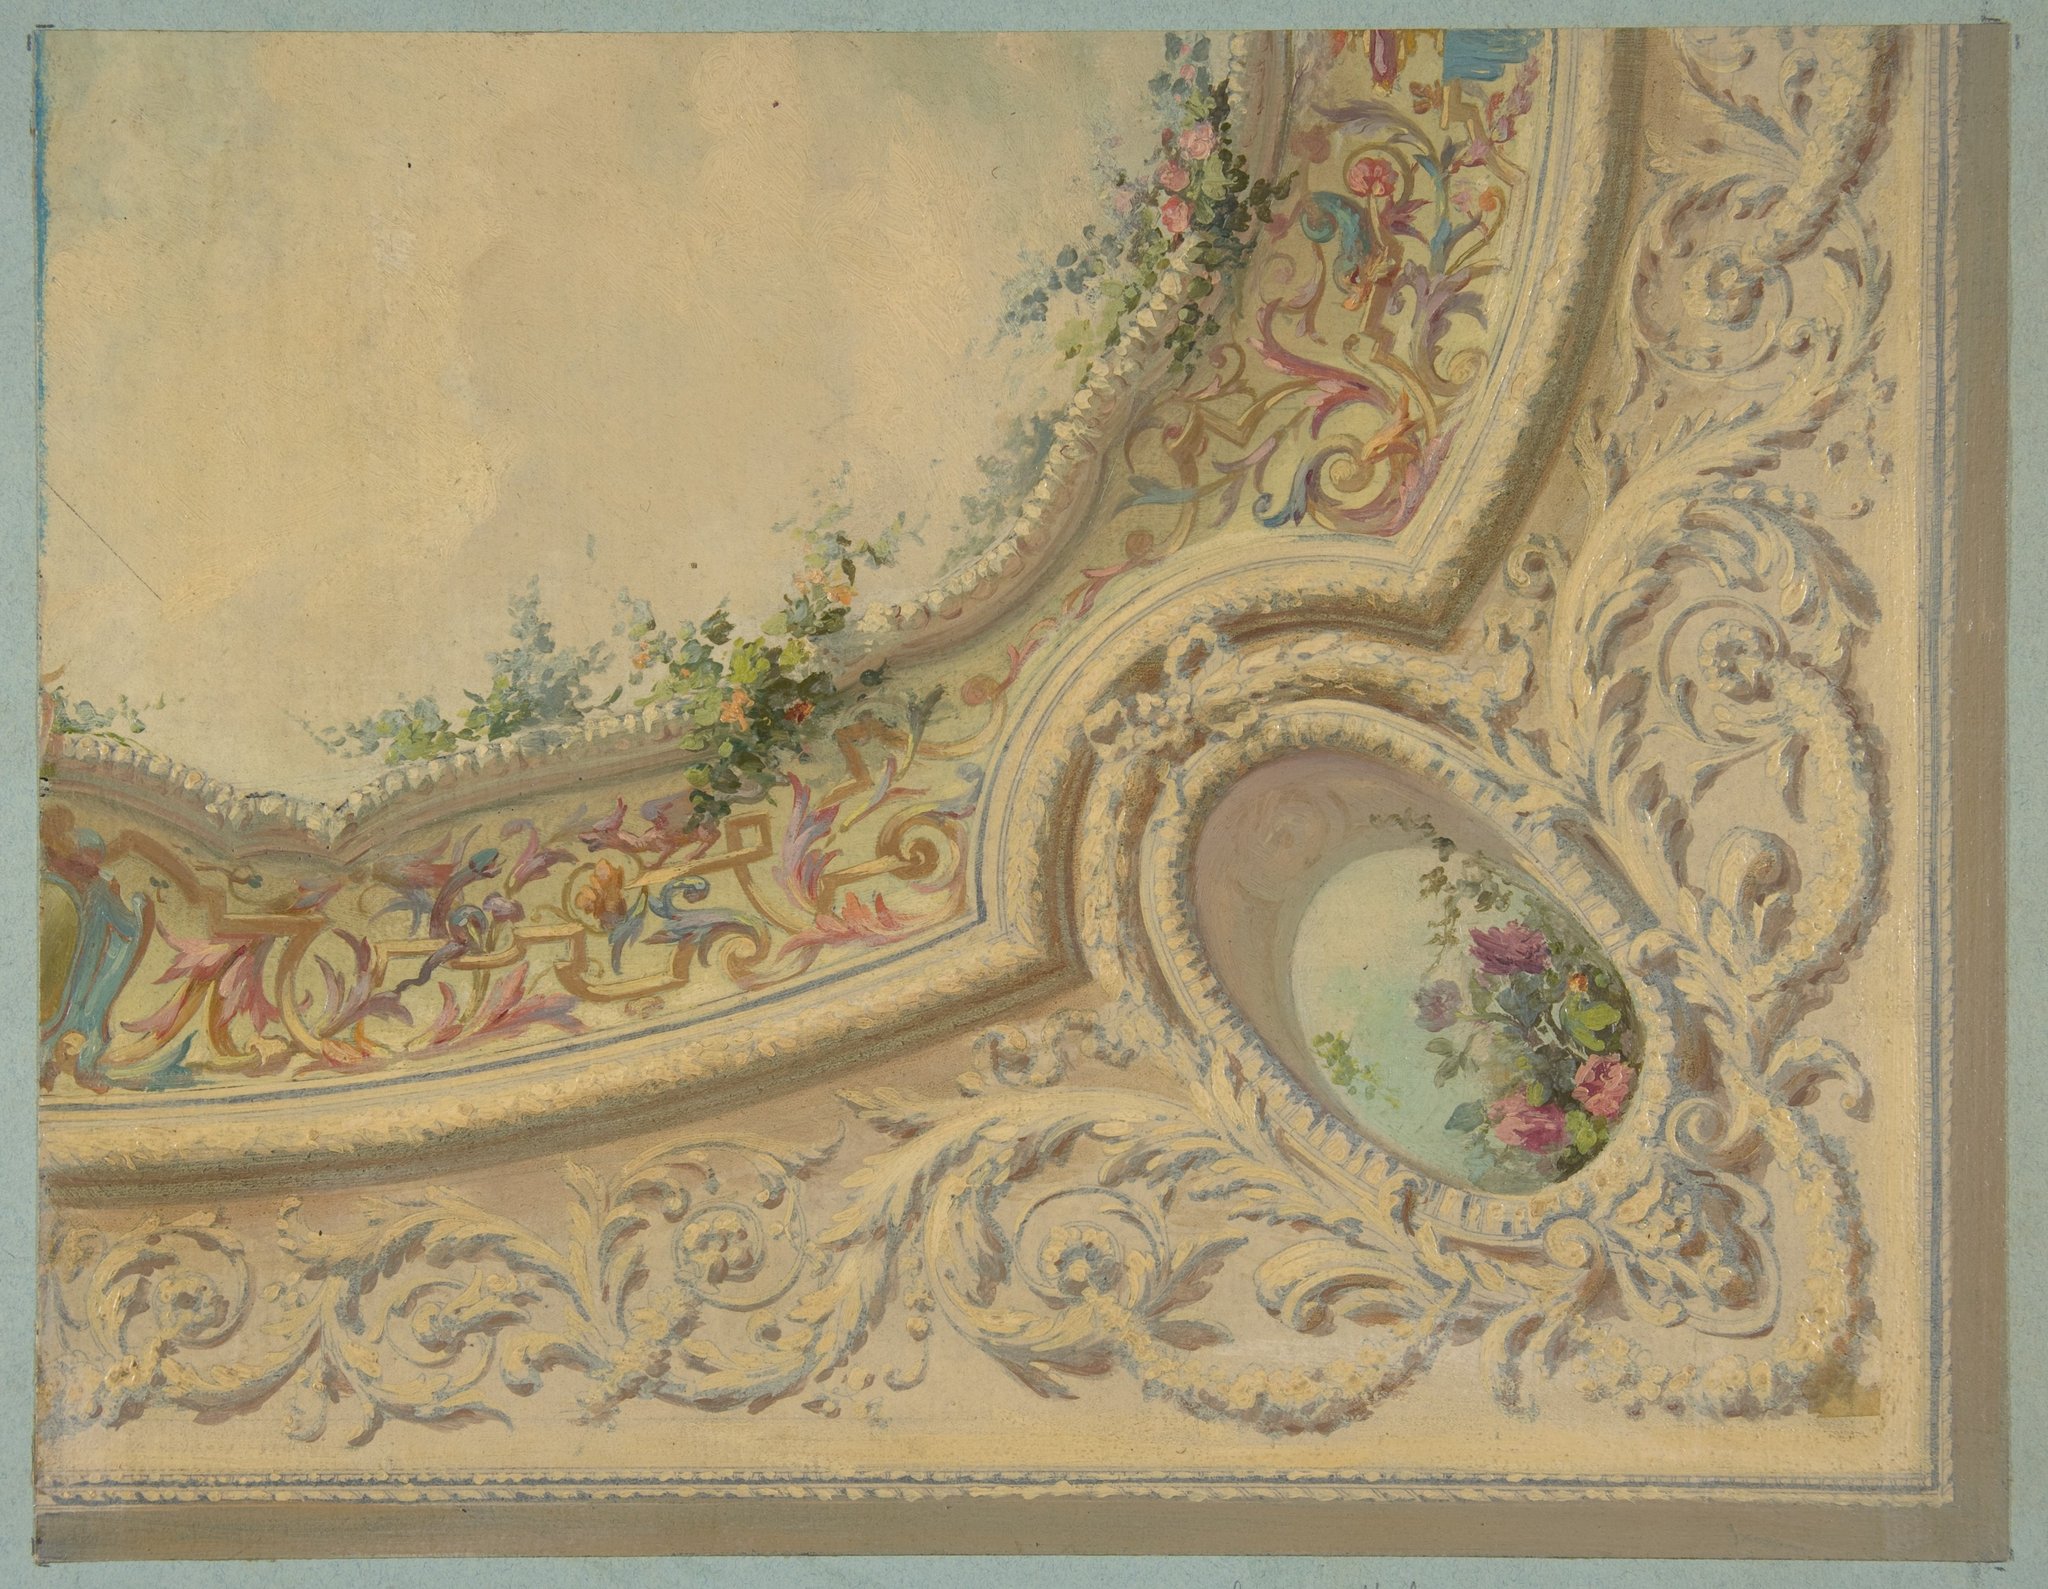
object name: drawing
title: Design for the decoration of a ceiling in the house of Baron Malet, Jouy-en-Josas (Seine et Gise)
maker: jules-edmond-charles lachaise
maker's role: artist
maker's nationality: french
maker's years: 1897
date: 1851-1900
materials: gouache, paper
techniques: inlay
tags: flowers,ceilings